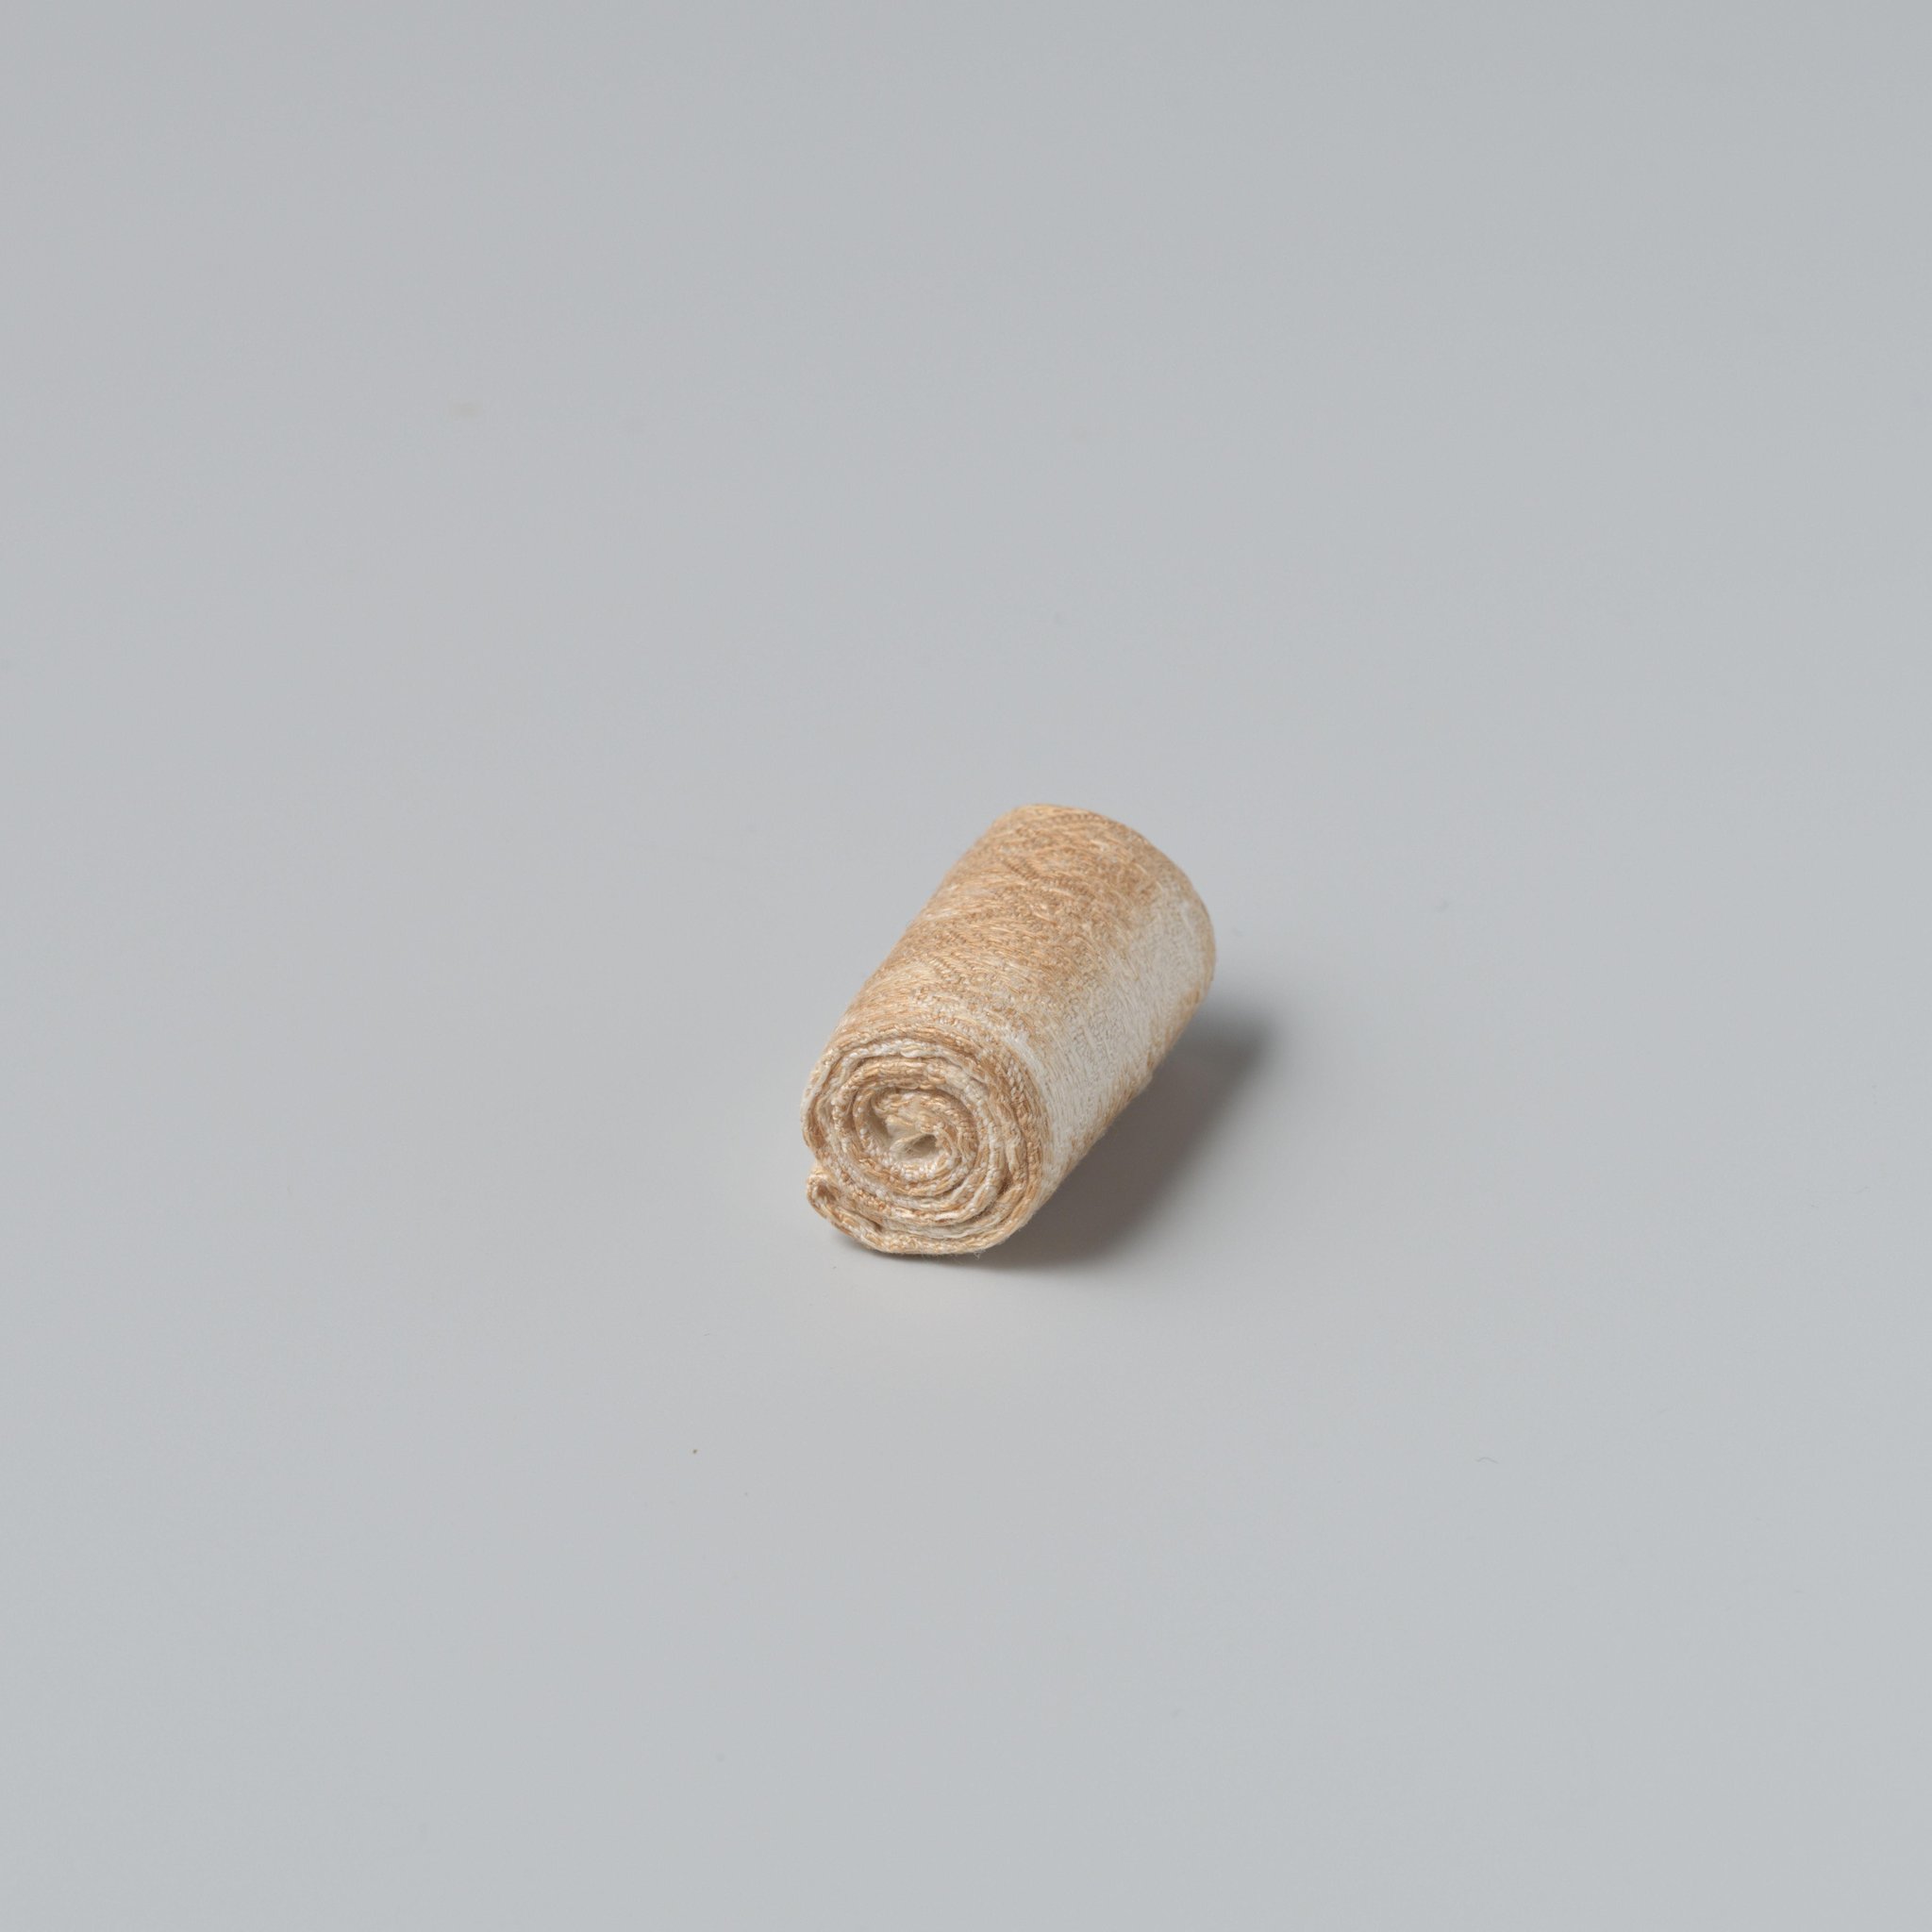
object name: miniature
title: Rol linnen, damastweefsel met pellenpatroon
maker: Anonymous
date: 1600-1699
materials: linen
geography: netherlands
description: Rol linnen, damastweefsel met pellenpatroon.